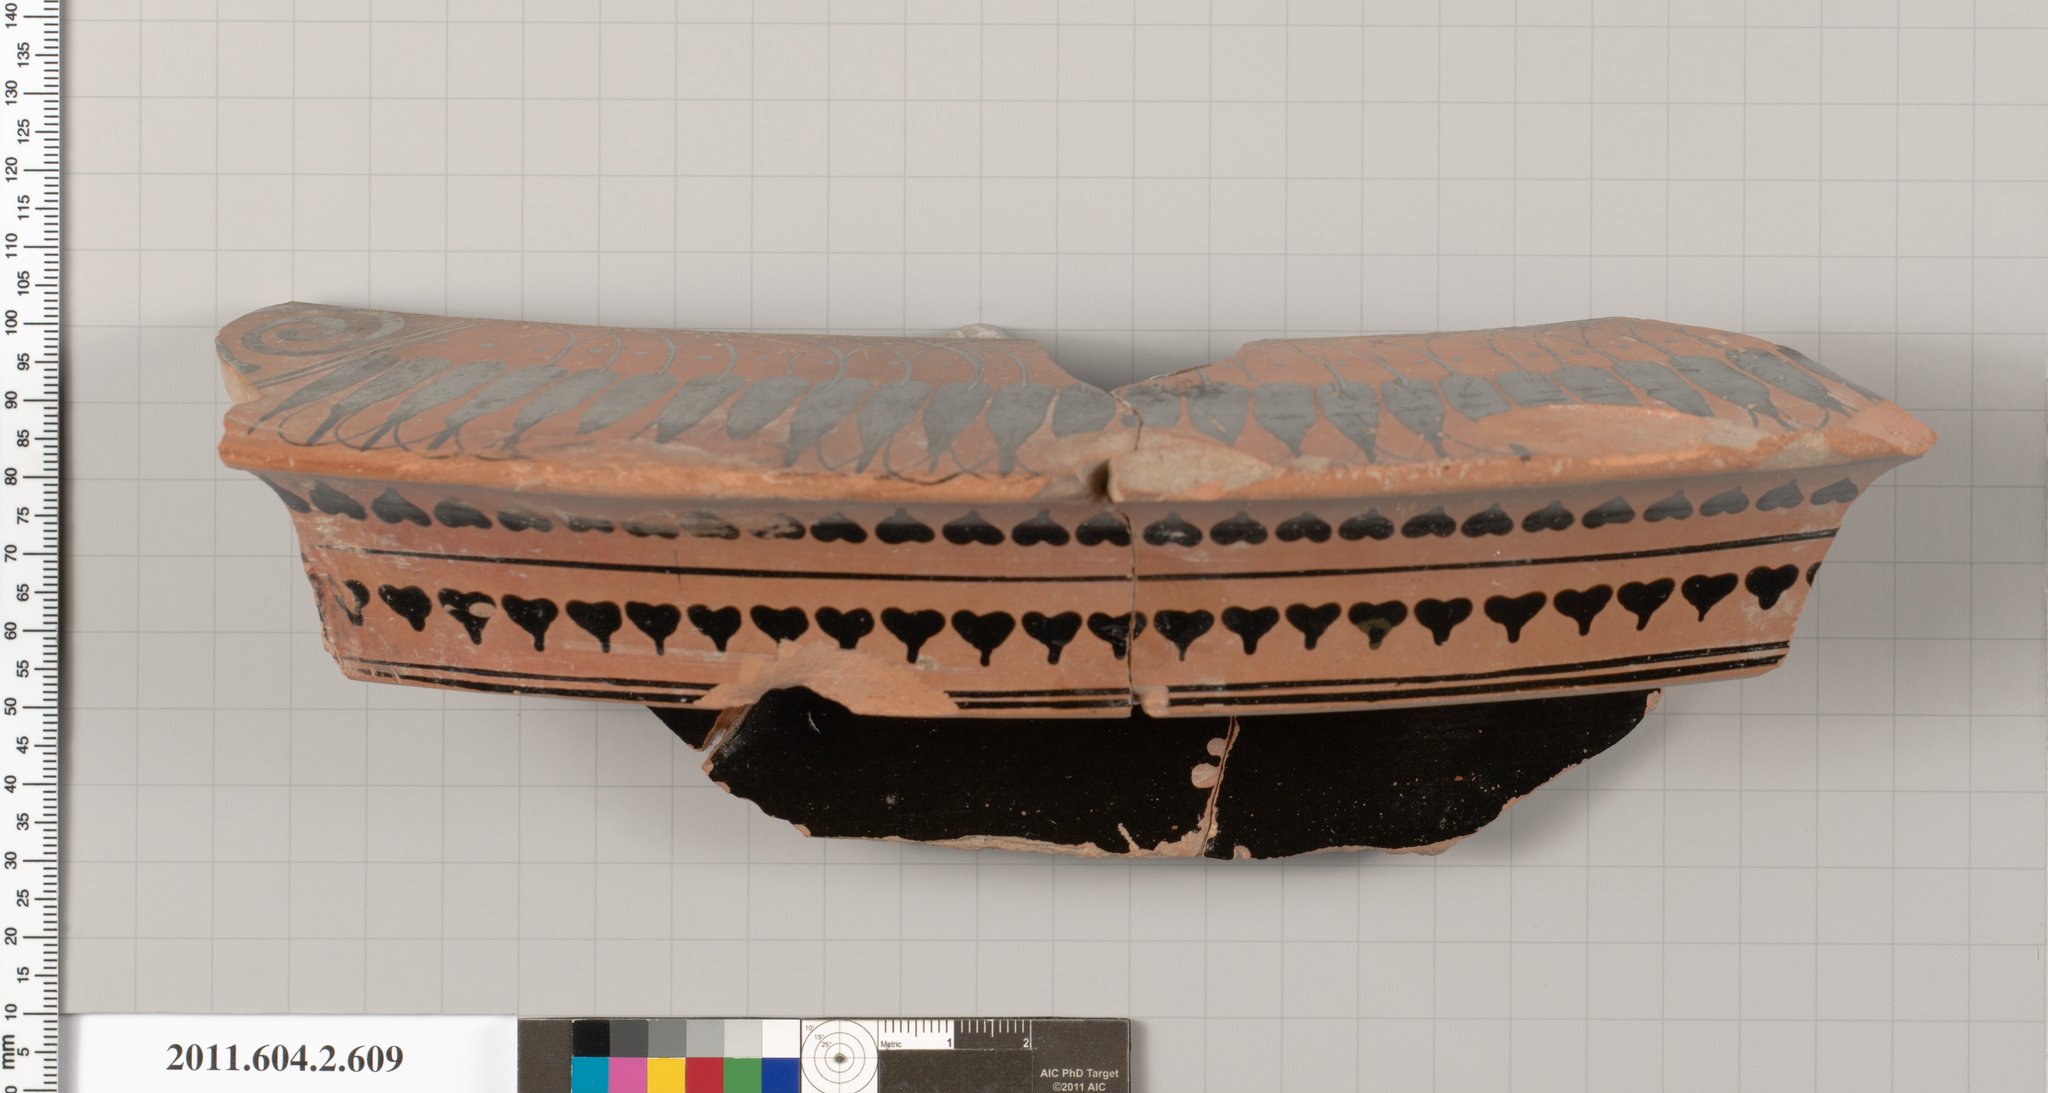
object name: column krater fragment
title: Terracotta fragment of a column-krater (bowl for mixing wine and water)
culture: greek, attic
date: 475-451 BCE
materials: terracotta